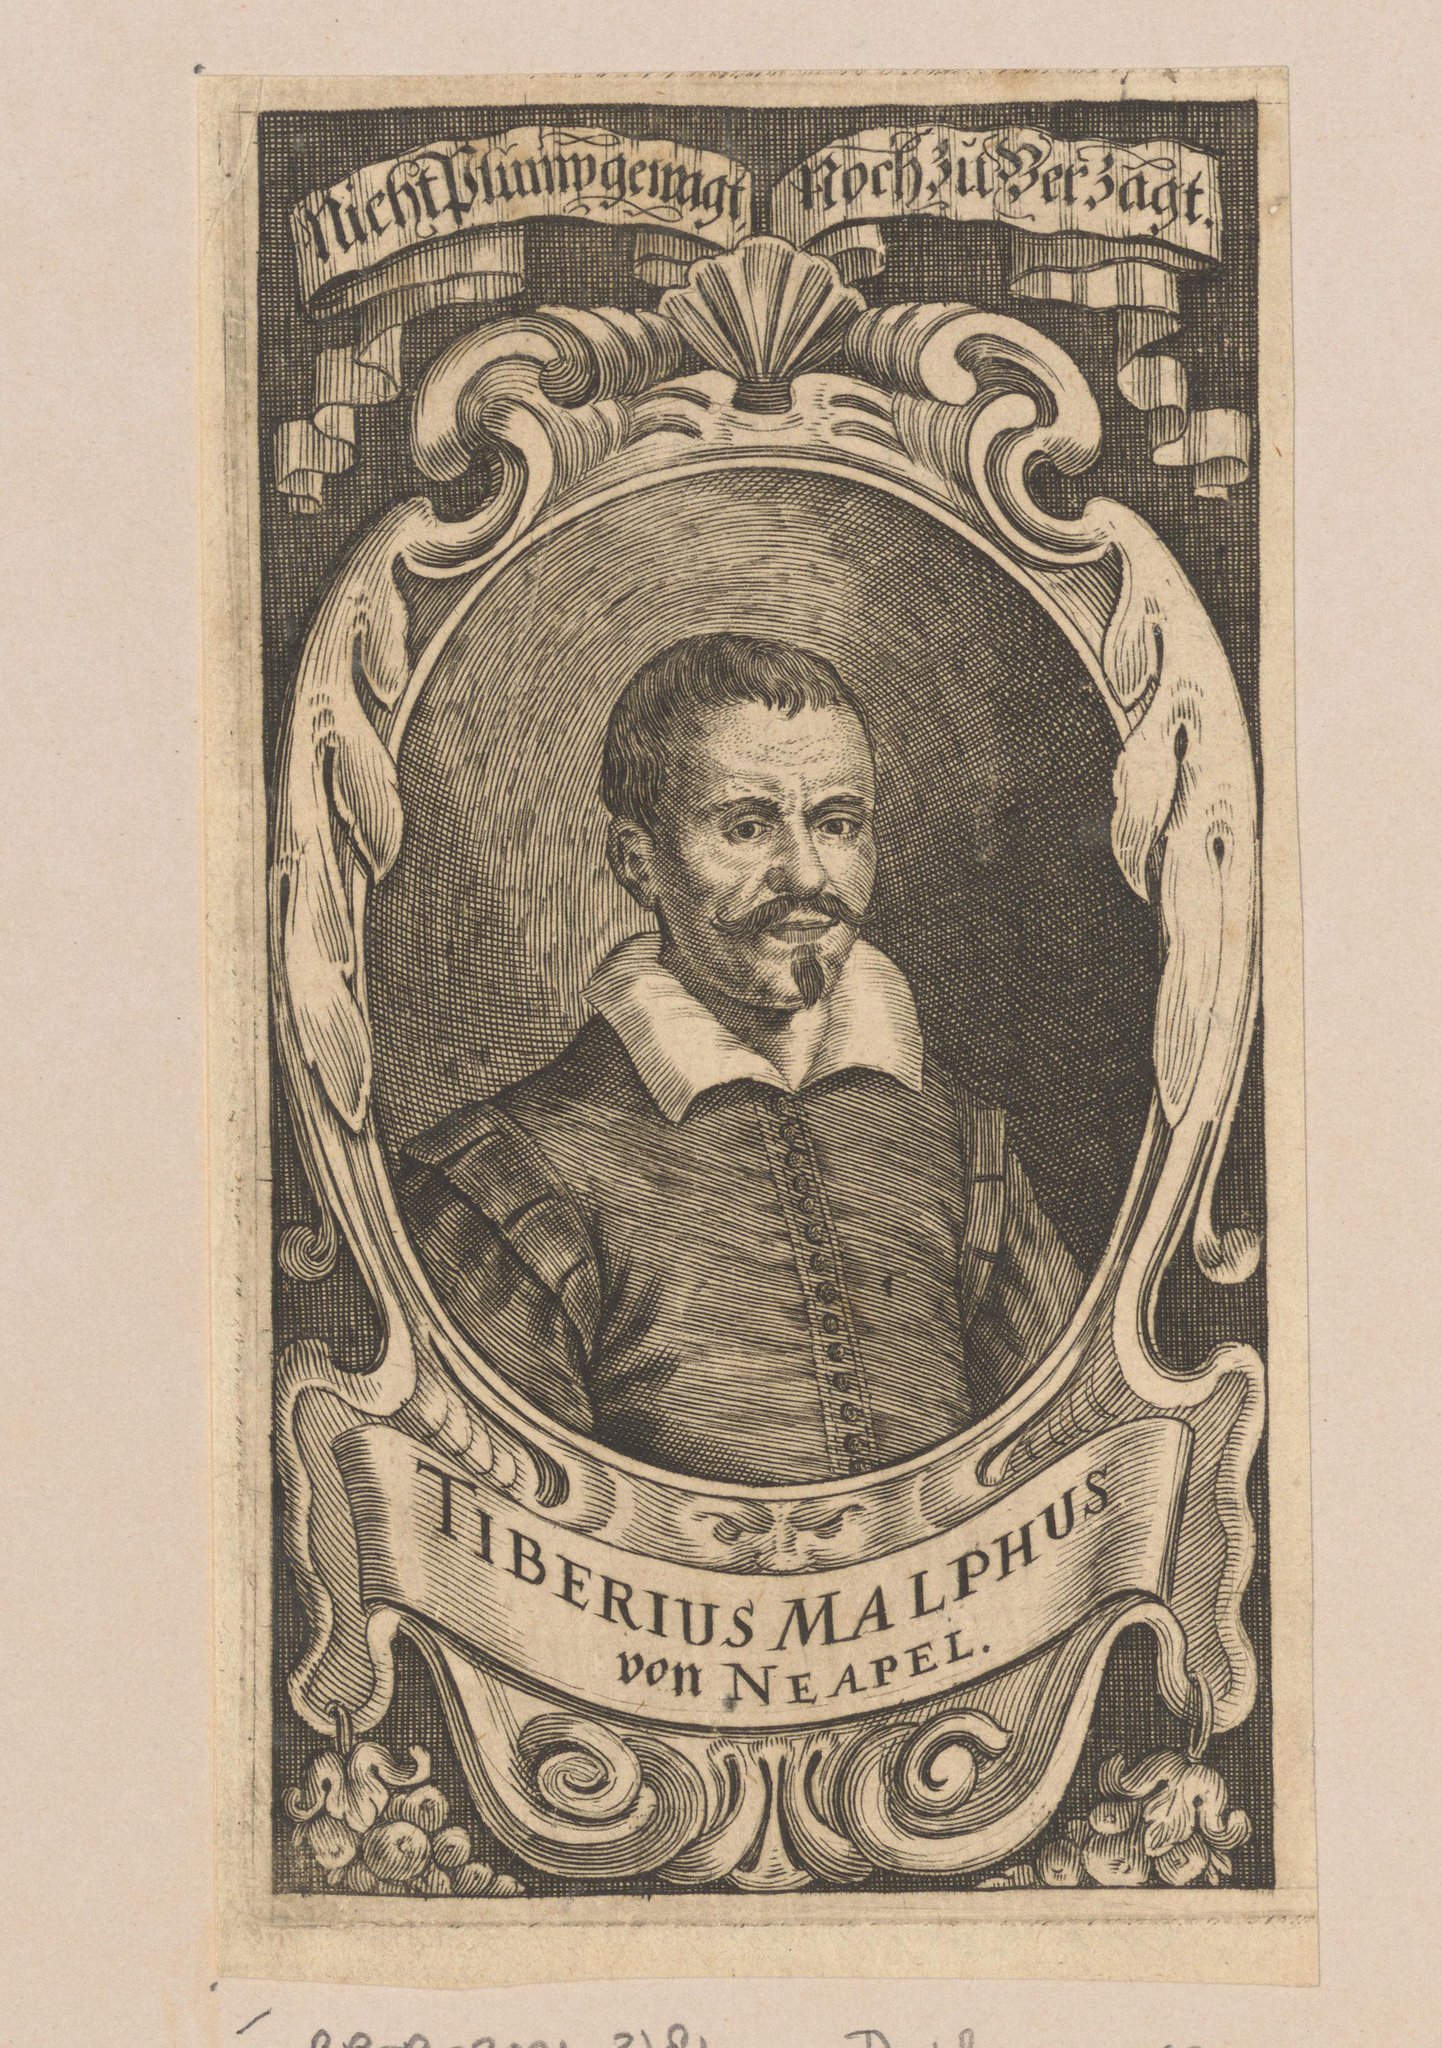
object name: book illustration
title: Portret van Tiberio Malfi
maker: Anonymous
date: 1676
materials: paper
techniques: engraving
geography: germany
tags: historical persons, physician, doctor (+ portrait of scholar, scientist)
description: Prent waarschijnlijk uit: Malfi, Tiberio. Neue Anleitung zur Barbier- und Wund-Artzney-Kunst (...). Neurenberg: Christoph Endters, 1676.